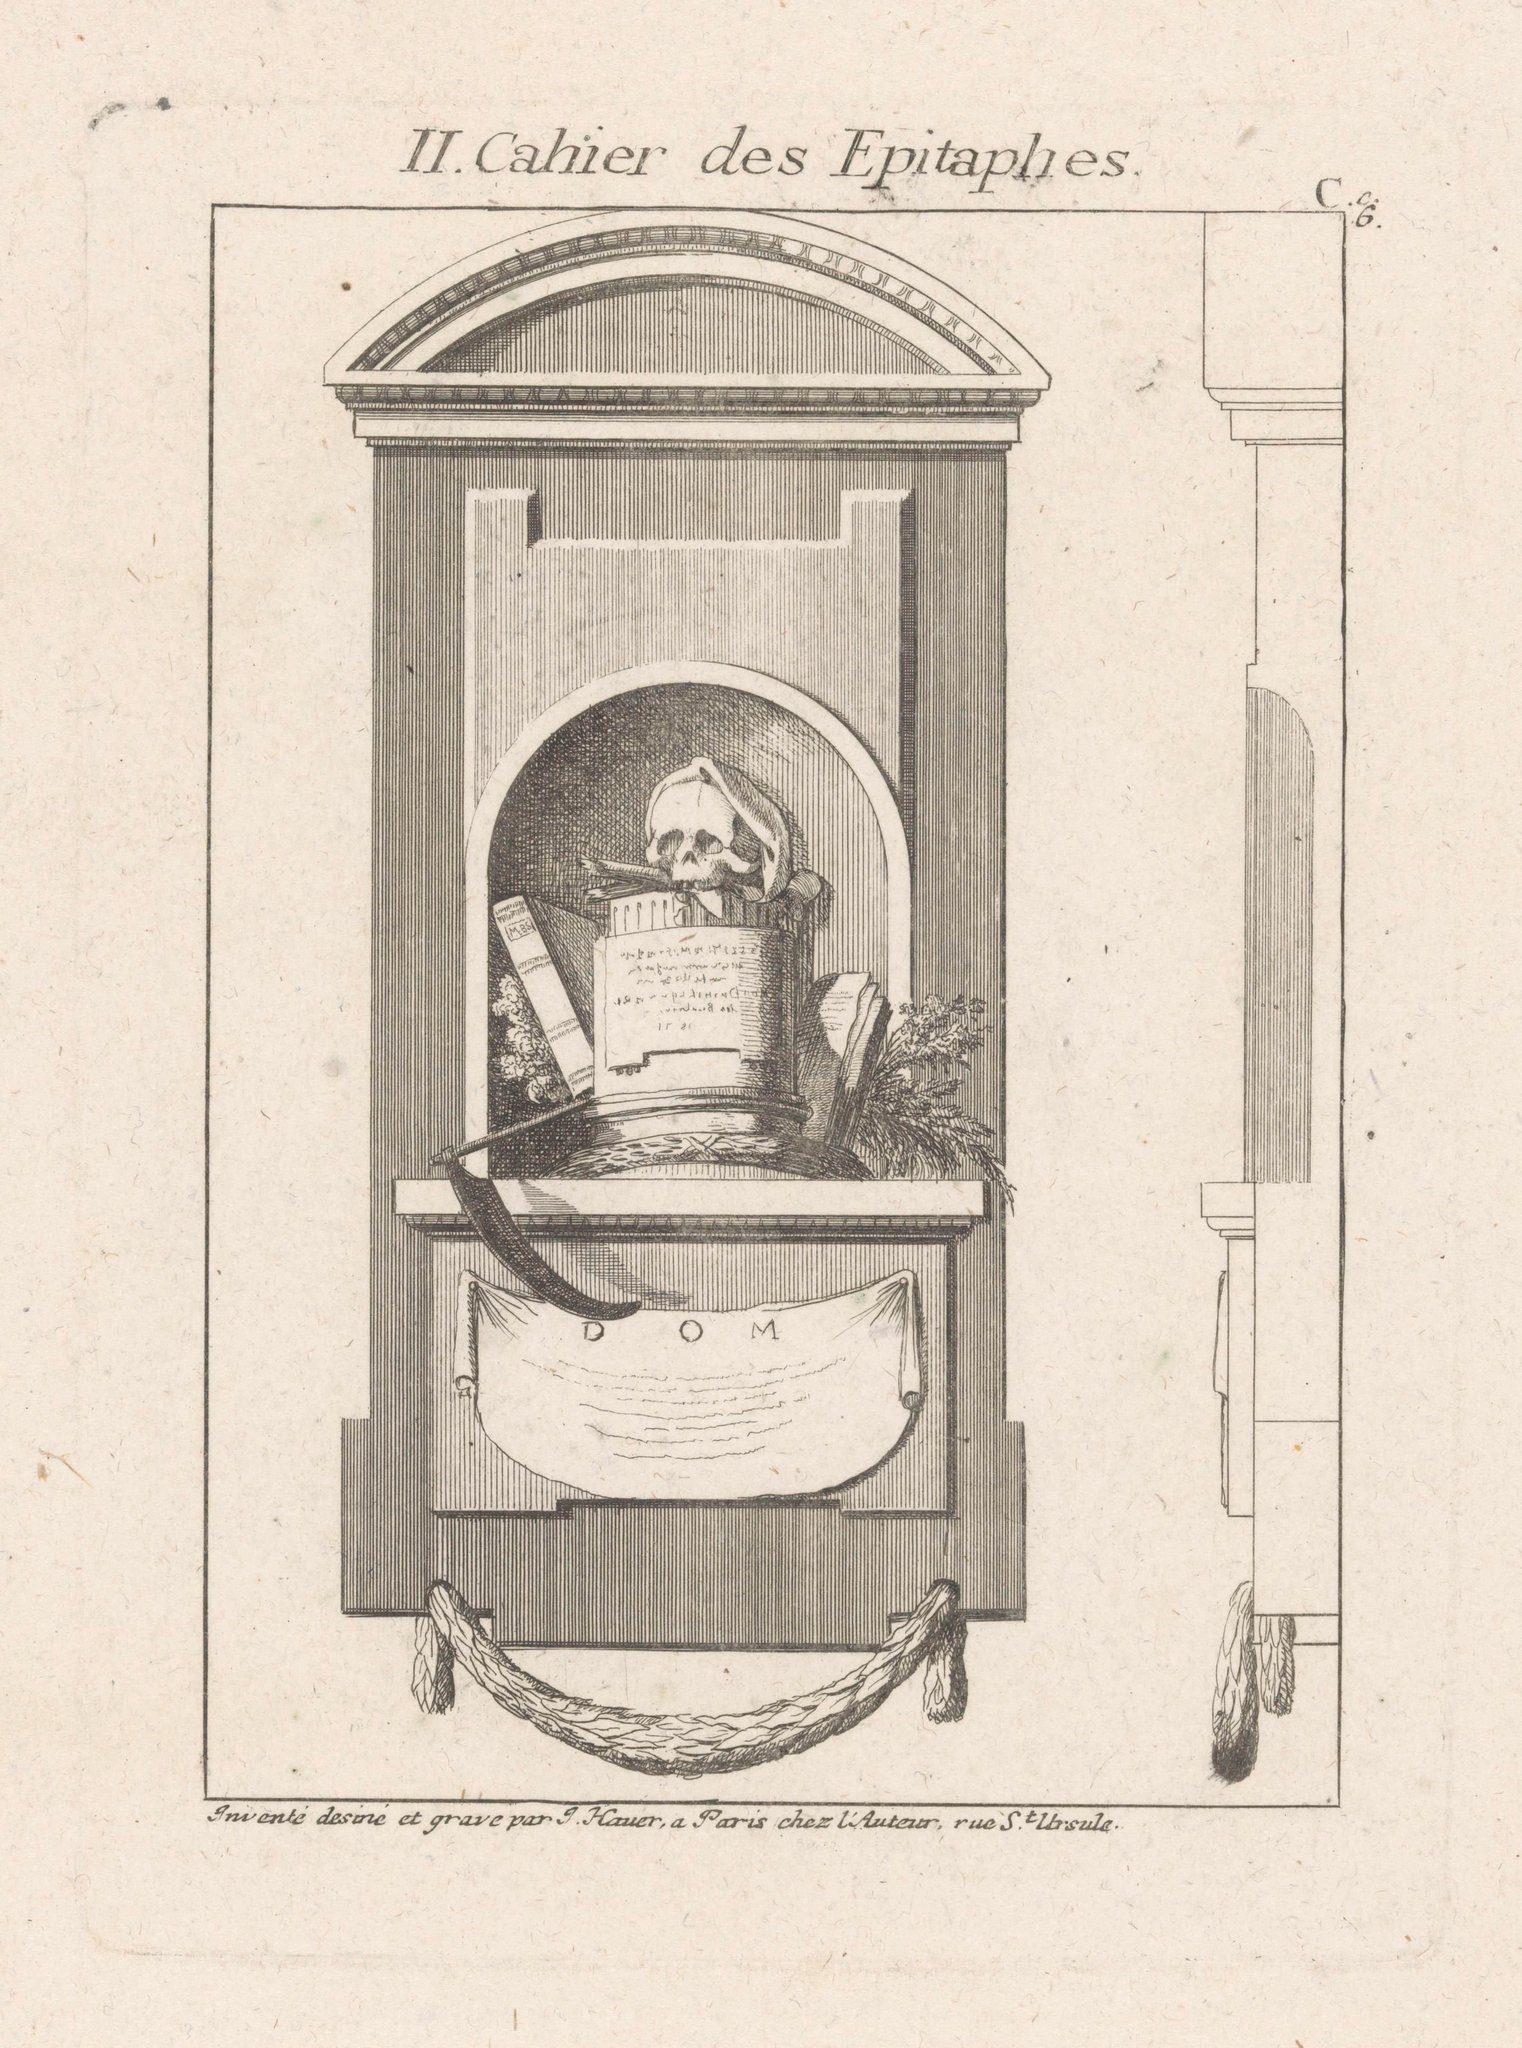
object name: ornament print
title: Desseins de la Mode neuve au Gout antique (...)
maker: johann thomas hauer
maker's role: print maker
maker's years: 1748-1820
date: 1781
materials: paper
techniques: engraving, etching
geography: paris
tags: epitaph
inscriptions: collector's mark: Lugt 2760, collector's mark: Lugt 2228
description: Ontwerp voor een epitaaf met doodshoofd, zeis, boek, krans en bloemen in nis en guirlande. Rechts een zijaanzicht.